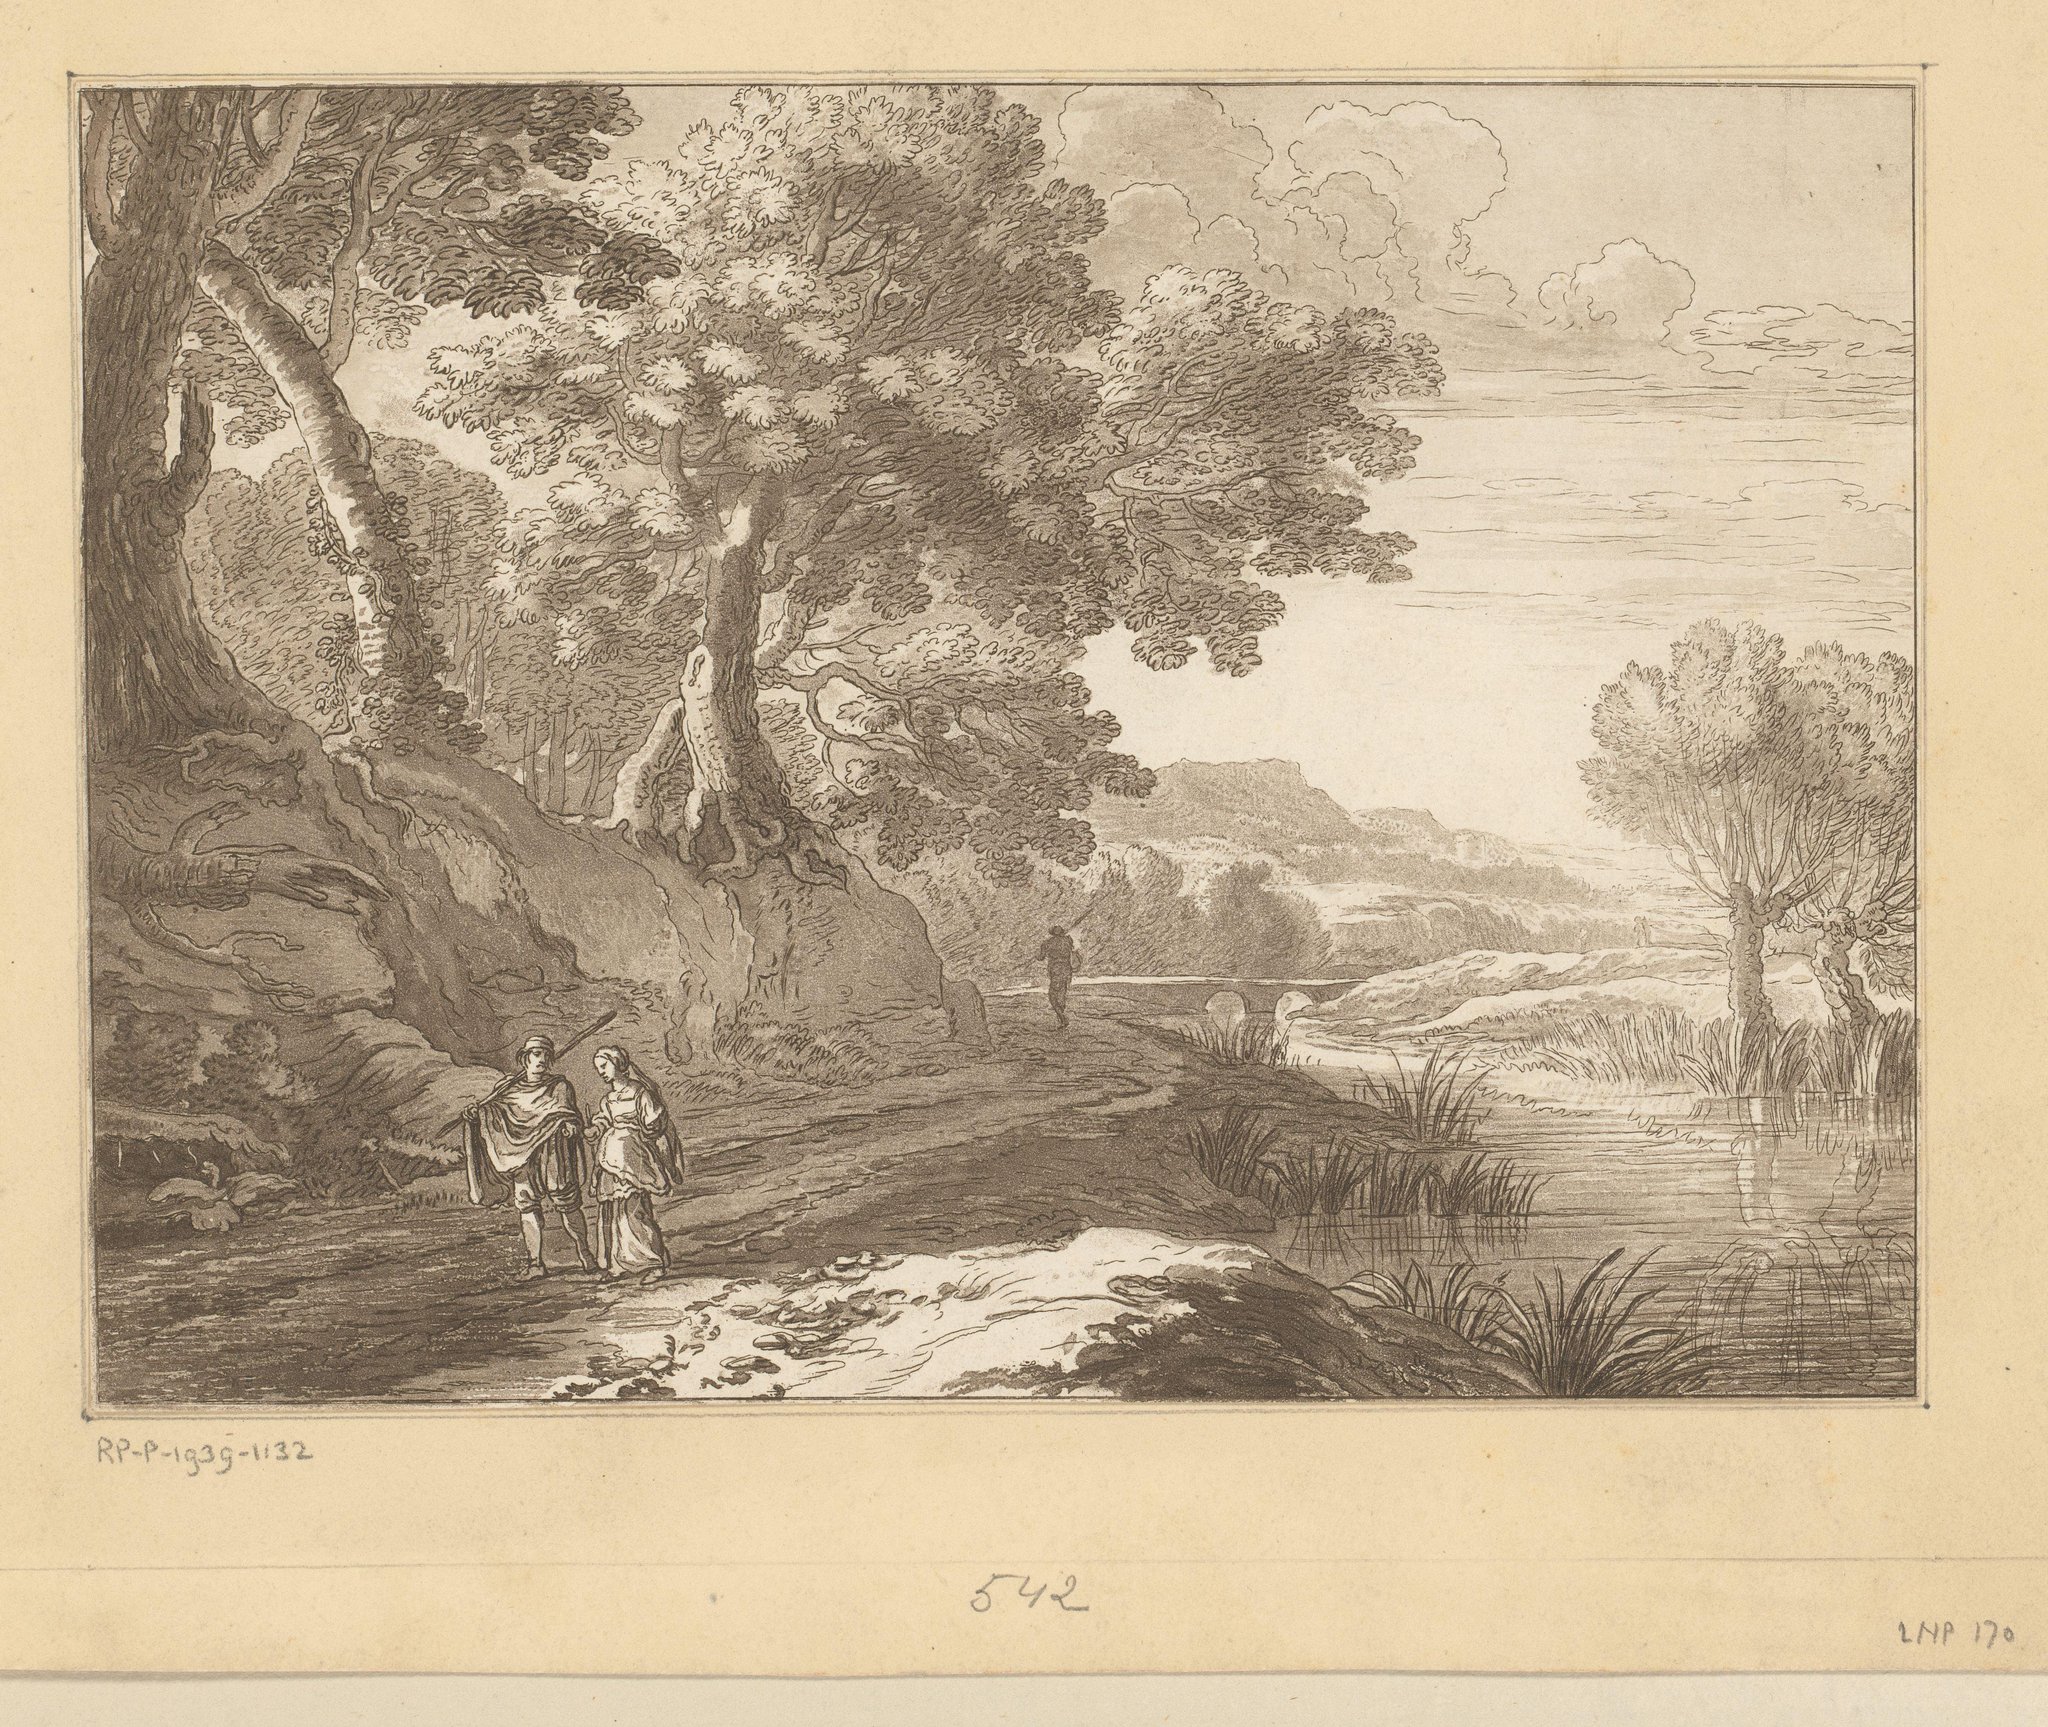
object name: print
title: Italianiserend landschap met drie wandelaars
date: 1741-1803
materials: paper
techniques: etching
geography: amsterdam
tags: river, 'en route', traveller under way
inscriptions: collector's mark: ‘RIJKS / MUSM’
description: Cornelis Brouwer heeft in samenwerking met C.S. Roos een aantal prenttekeningen uitgegeven welke op het verso het signatuur C.Brouwer fecit en C.S. Roos excudit Amst. dragen. De prent werd opgenomen in: Collection d'imitations de dessins d'après les principaux maîtres hollandais et flamands, Londen, C. Josi, 1821.